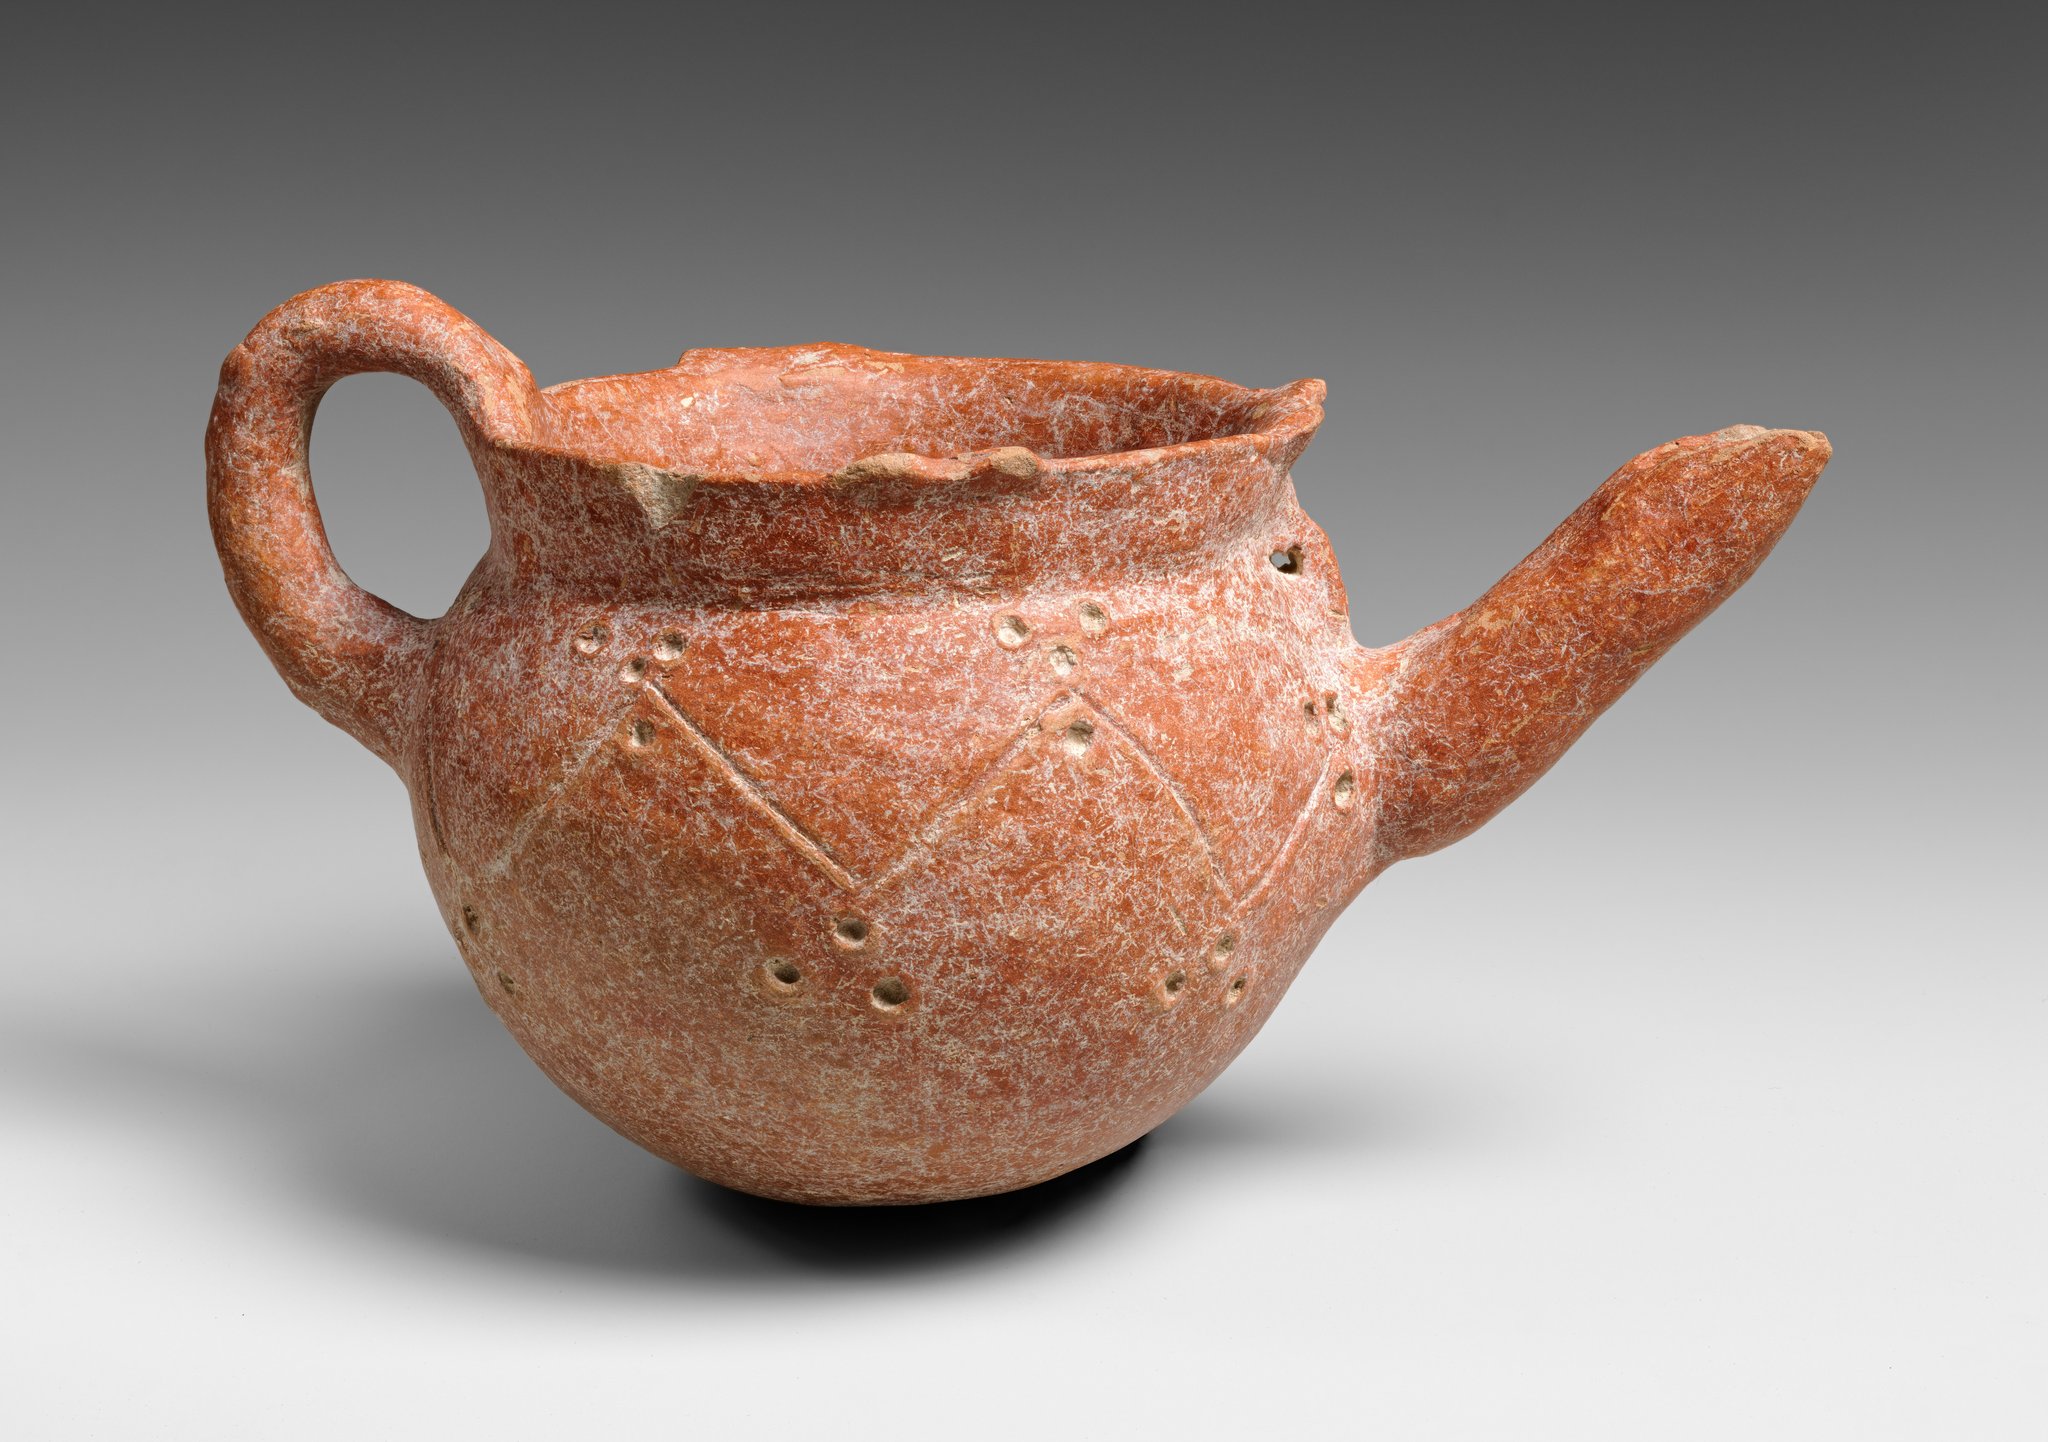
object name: bowl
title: Terracotta jug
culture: cypriot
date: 1900-1600 BCE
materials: terracotta